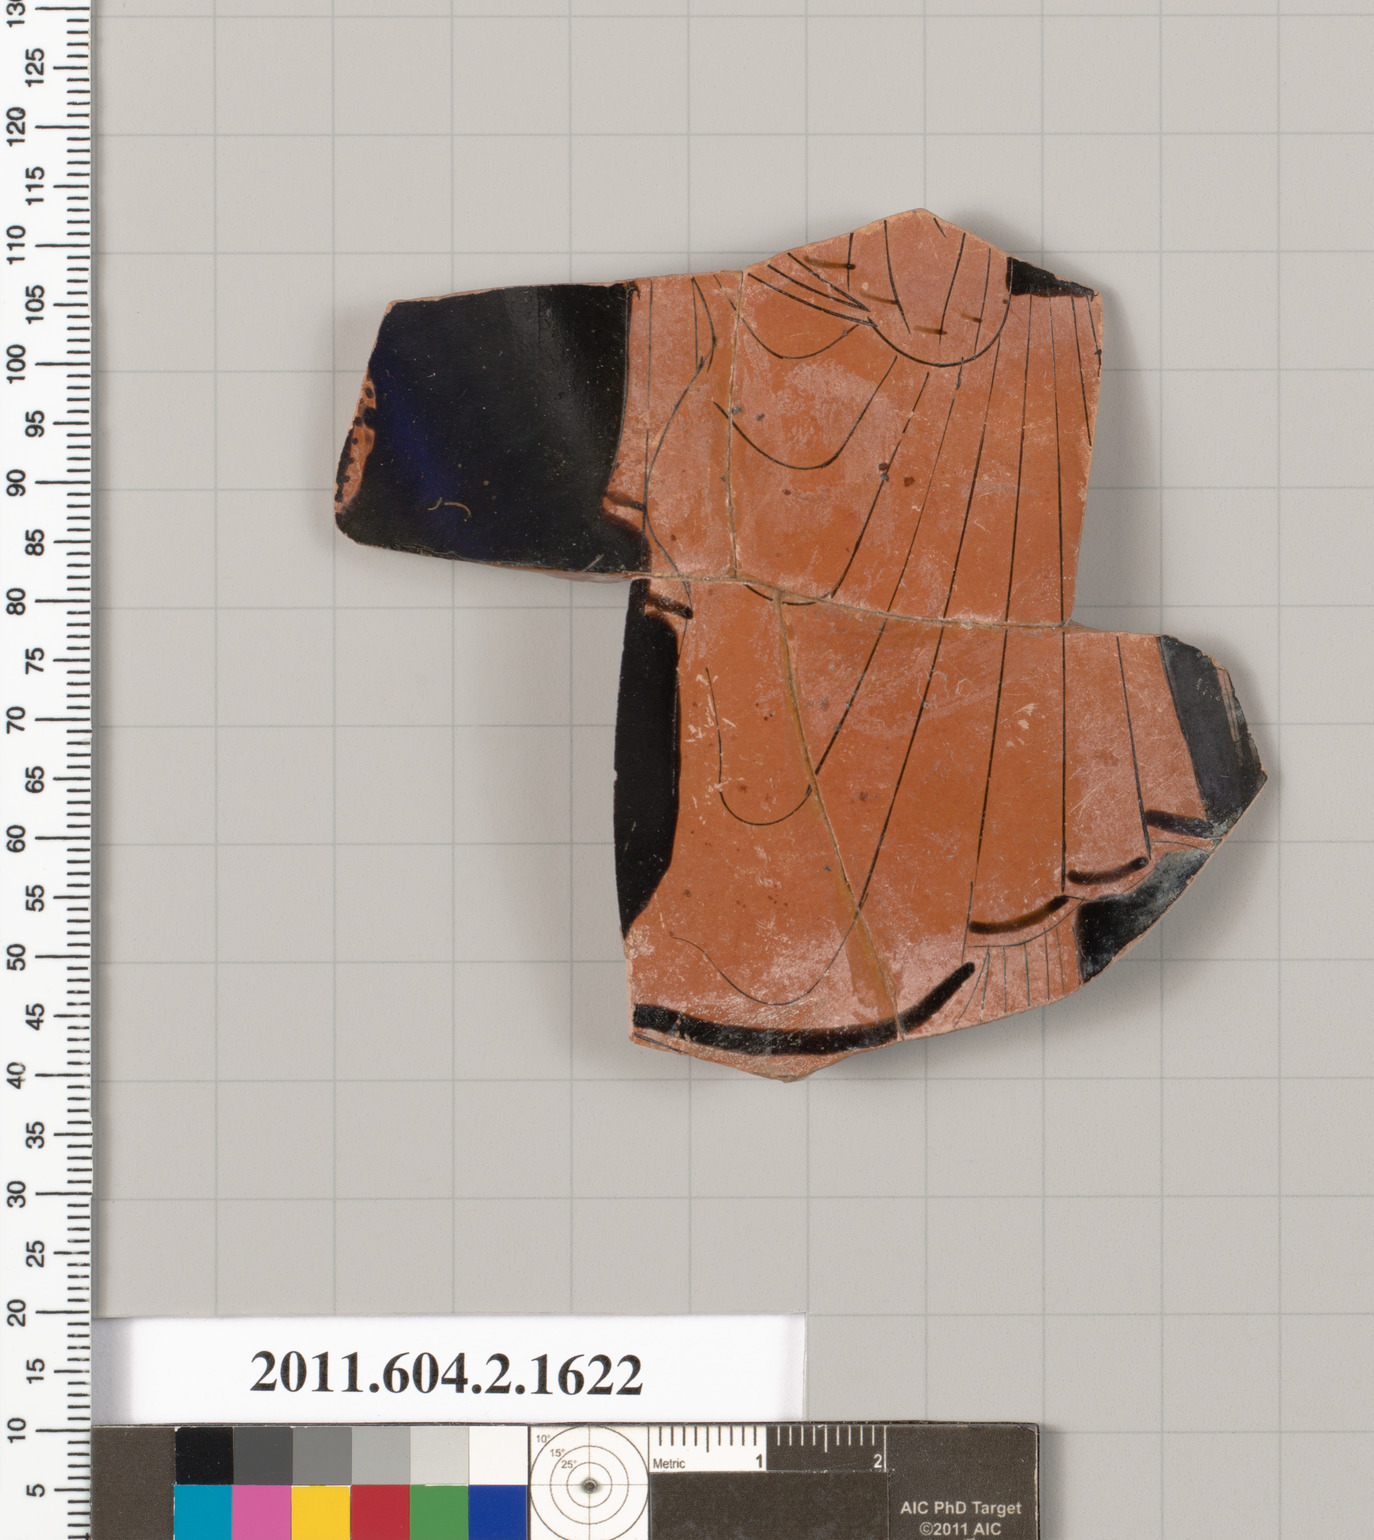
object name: skyphos fragment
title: Terracotta fragment of a skyphos (deep drinking cup)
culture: greek, attic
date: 460-440 BCE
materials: terracotta